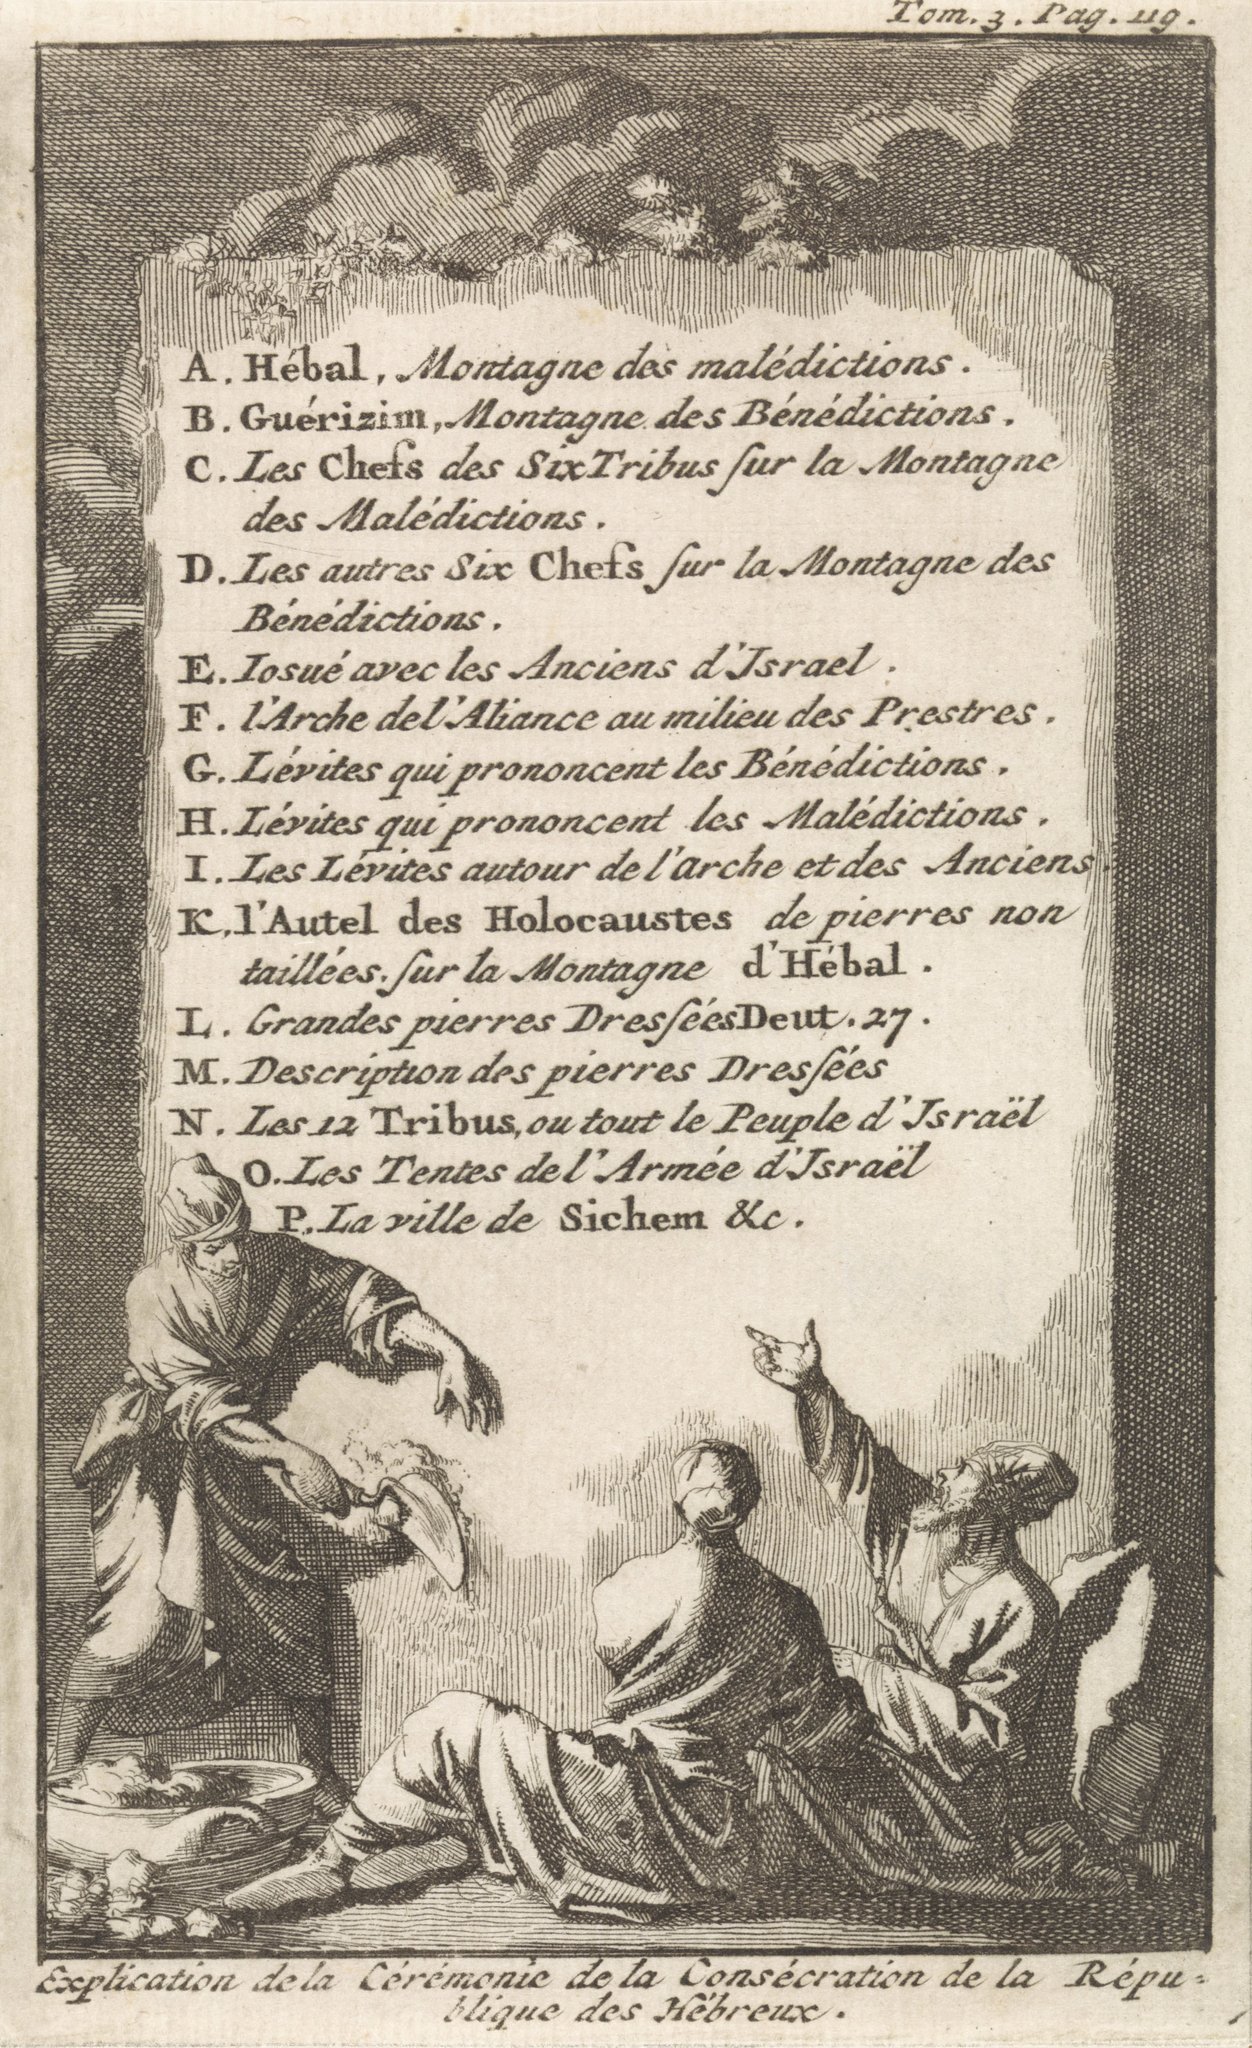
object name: print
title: Stenen tablet met de voorschriften van Mozes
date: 1705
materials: paper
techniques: etching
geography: amsterdam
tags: the reading of the law (joshua 8:30-35)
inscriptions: collector's mark: Lugt 2228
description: Illustratie uit: Cunaeus, Petrus. La republique des Hebreux, 3 delen. Amsterdam: Pieter Mortier, 1705, dl. III, p. 119.